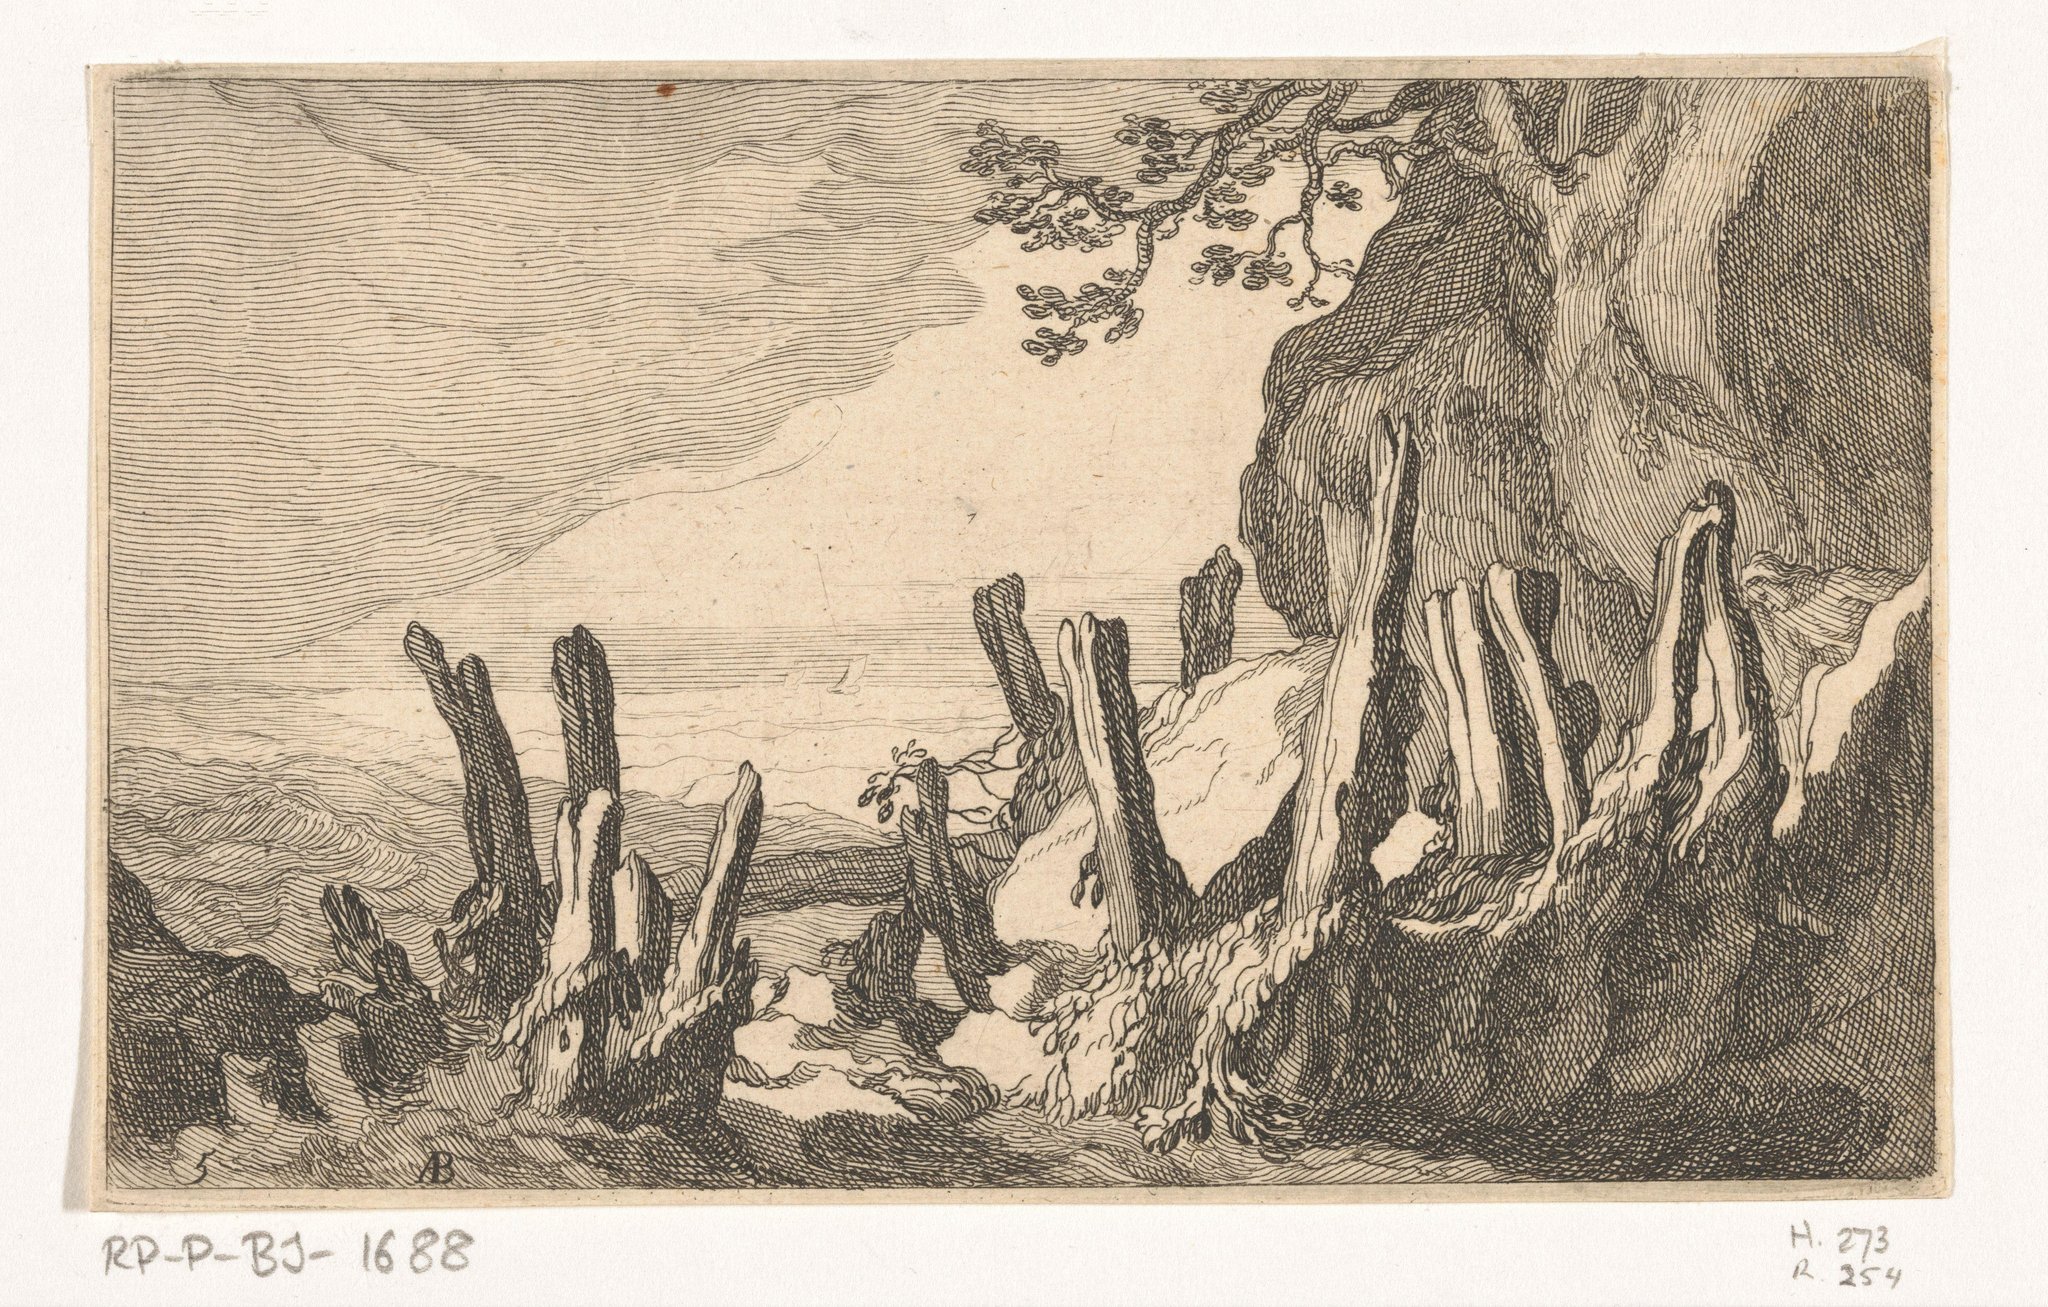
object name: print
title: Kustlandschap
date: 1635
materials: paper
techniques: engraving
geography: utrecht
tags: sea (seascape)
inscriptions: collector's mark: Lugt 240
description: Rottende palen in het water langs de kust temidden van rotsen. Rechts, nauwelijks zichtbaar tussen de rotsen, een vrouw.